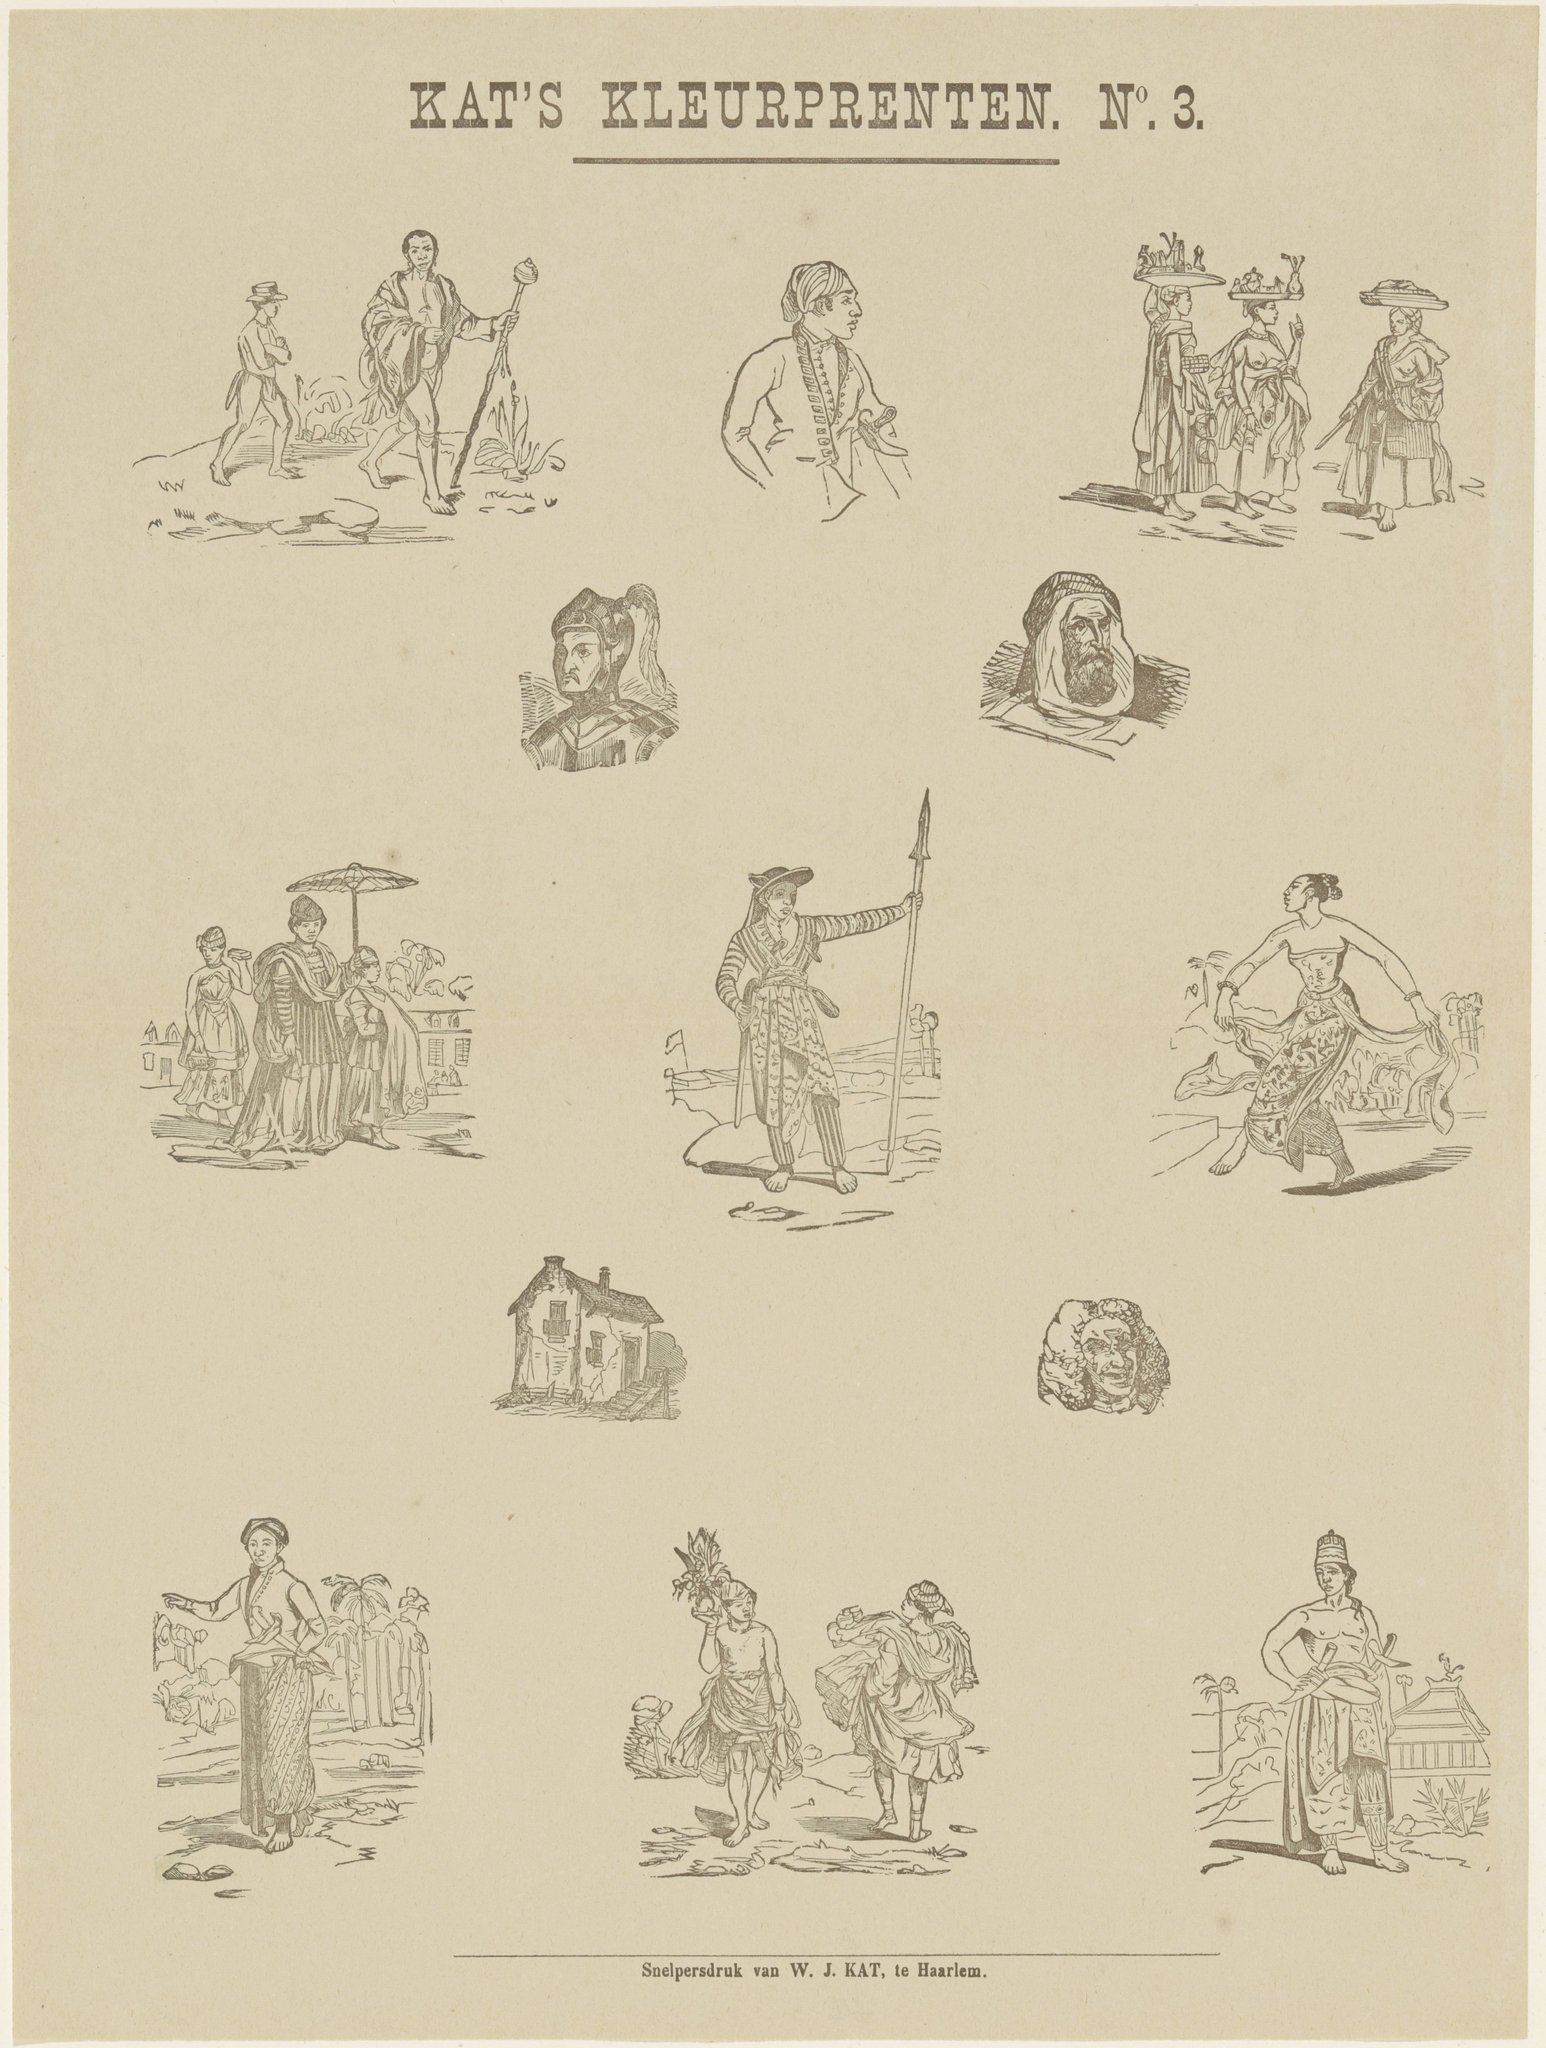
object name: print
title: Verschillende voorstellingen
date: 1862-1882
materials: paper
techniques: engraving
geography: haarlem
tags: asiatic races and peoples, caricatures (human types), africans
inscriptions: collector's mark: Lugt 2760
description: Blad met 13 afbeeldingen van verschillende onderwerpen, bedoeld om uit te knippen en in te kleuren. Weergegeven zijn onder meer karikaturen en mensen uit verschillende culturen. Genummerd rechtsboven: No. 3.